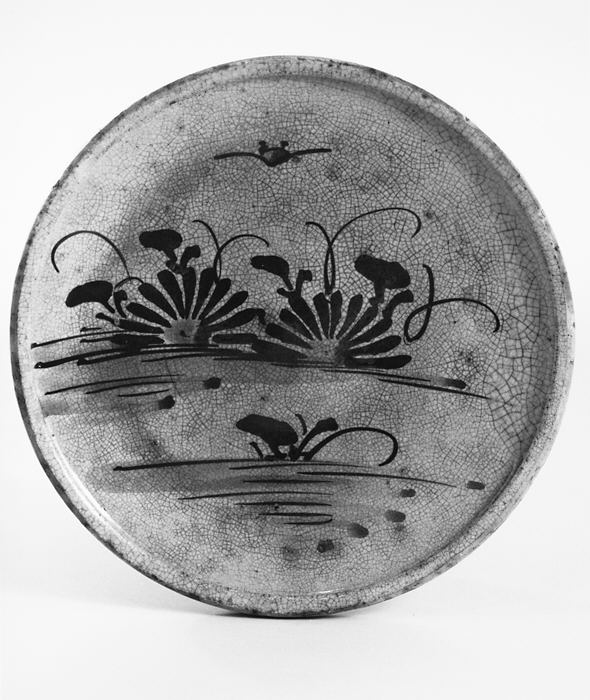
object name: plate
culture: japanese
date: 1801-1900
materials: iron, pigment, pottery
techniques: painting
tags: flowers